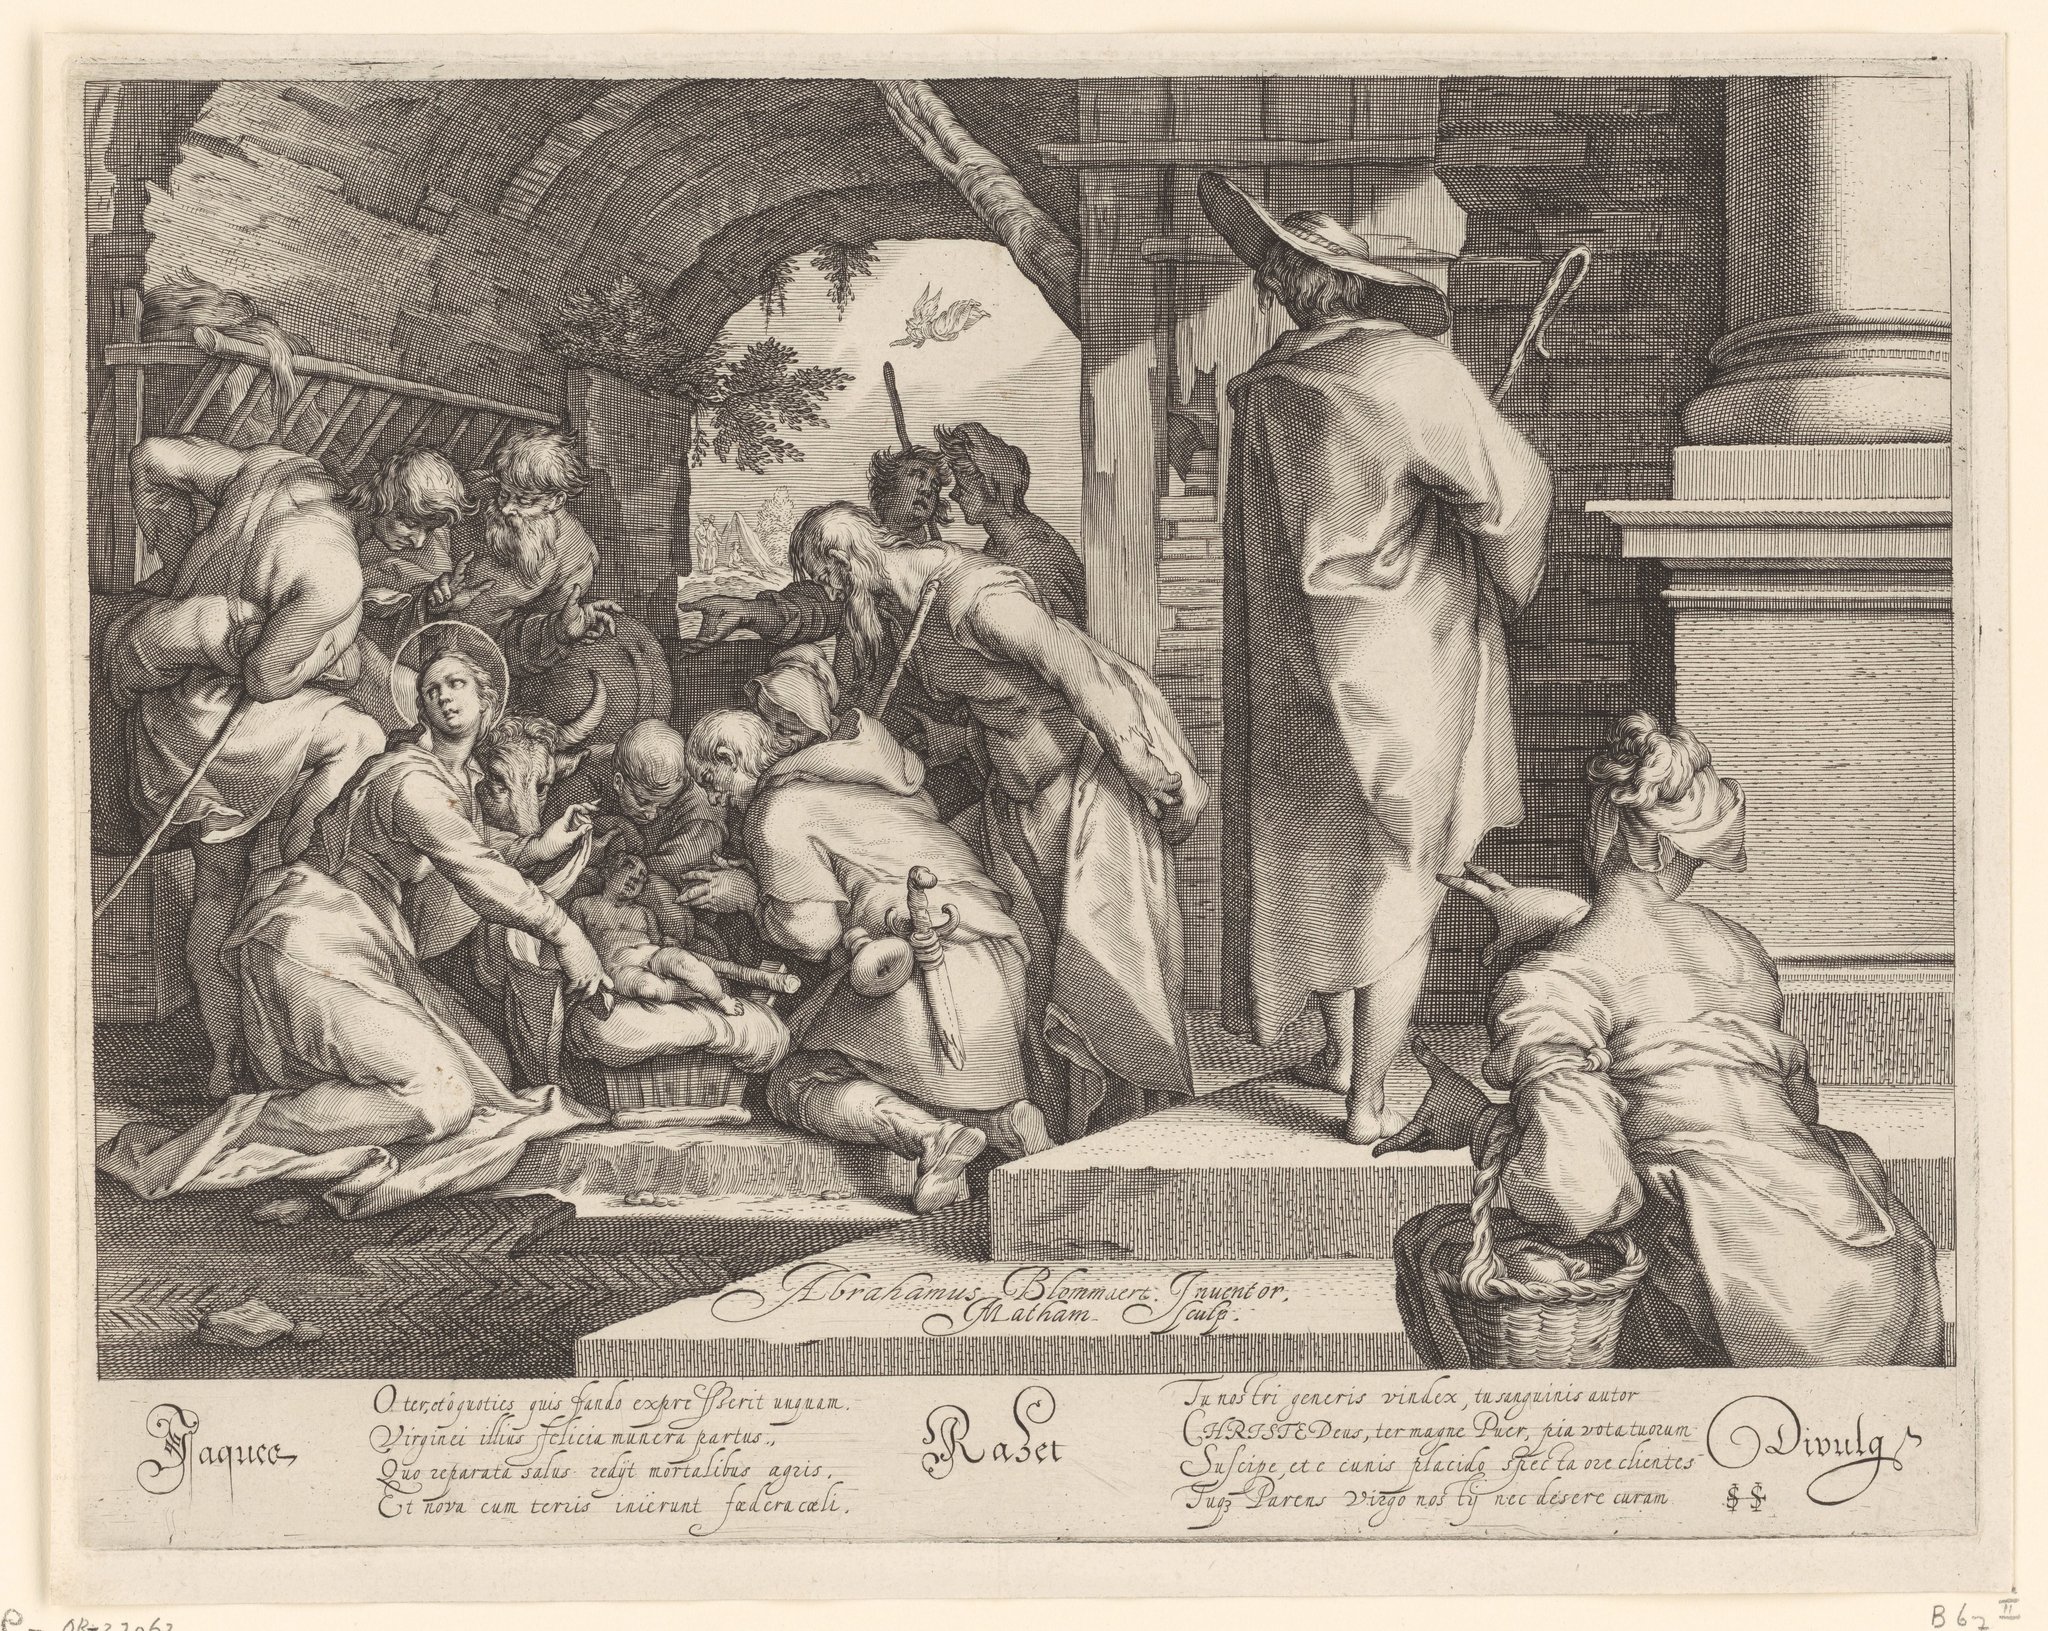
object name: print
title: Aanbidding der herders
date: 1604-1607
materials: paper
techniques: engraving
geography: haarlem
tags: adoration of the christ-child by the shepherds; mary and joseph present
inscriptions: collector's mark: Lugt 240